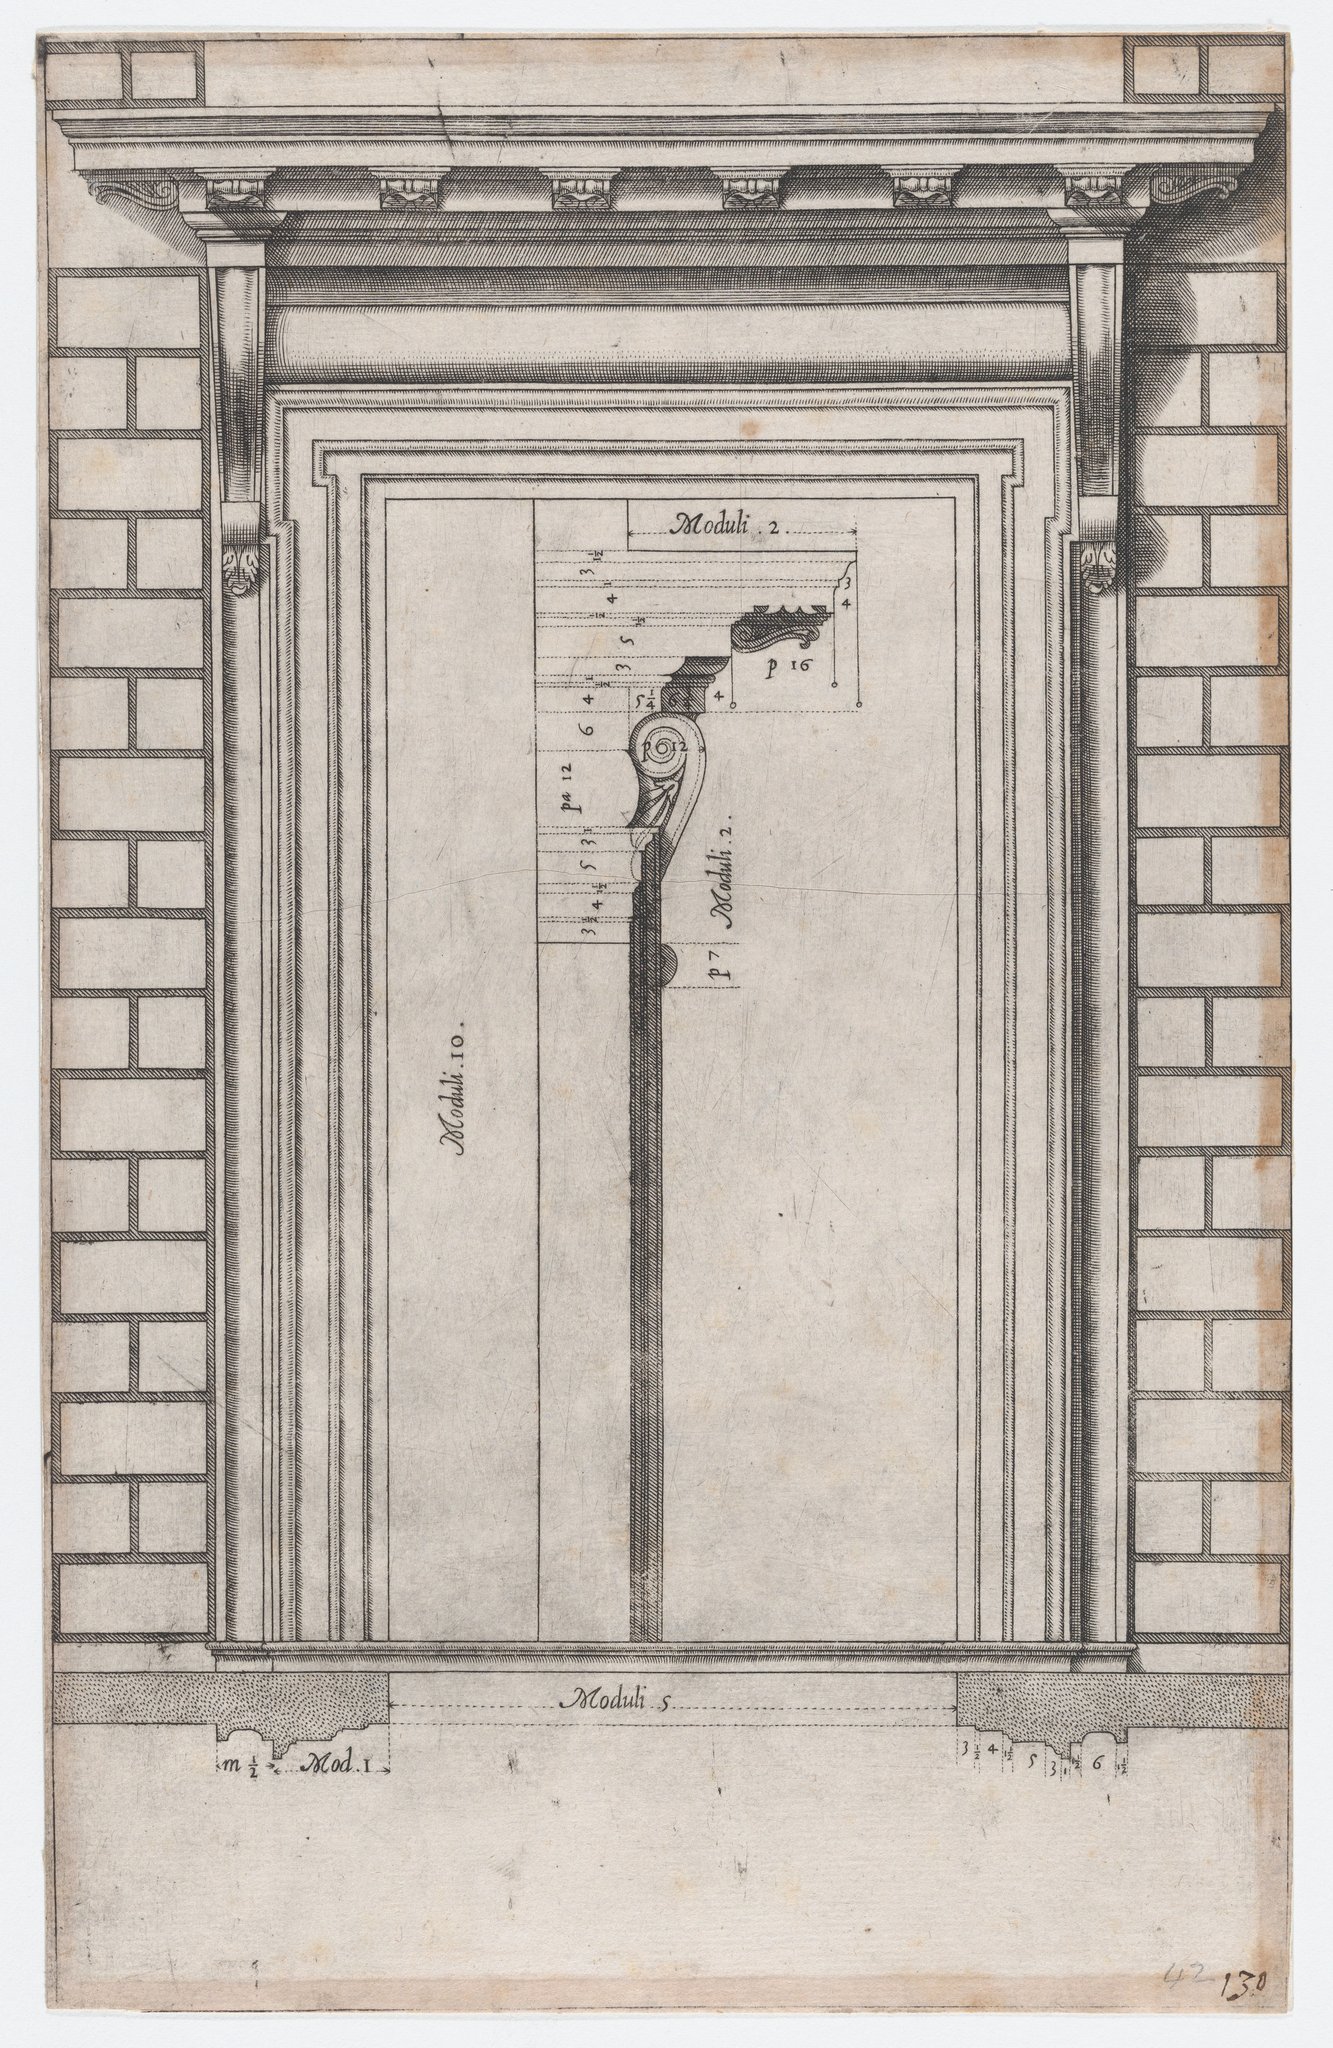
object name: print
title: Plan of a doorway, from "Speculum Romanae Magnificentiae"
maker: Anonymous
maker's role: artist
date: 1501-1600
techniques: engraving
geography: rome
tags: doorways,rome